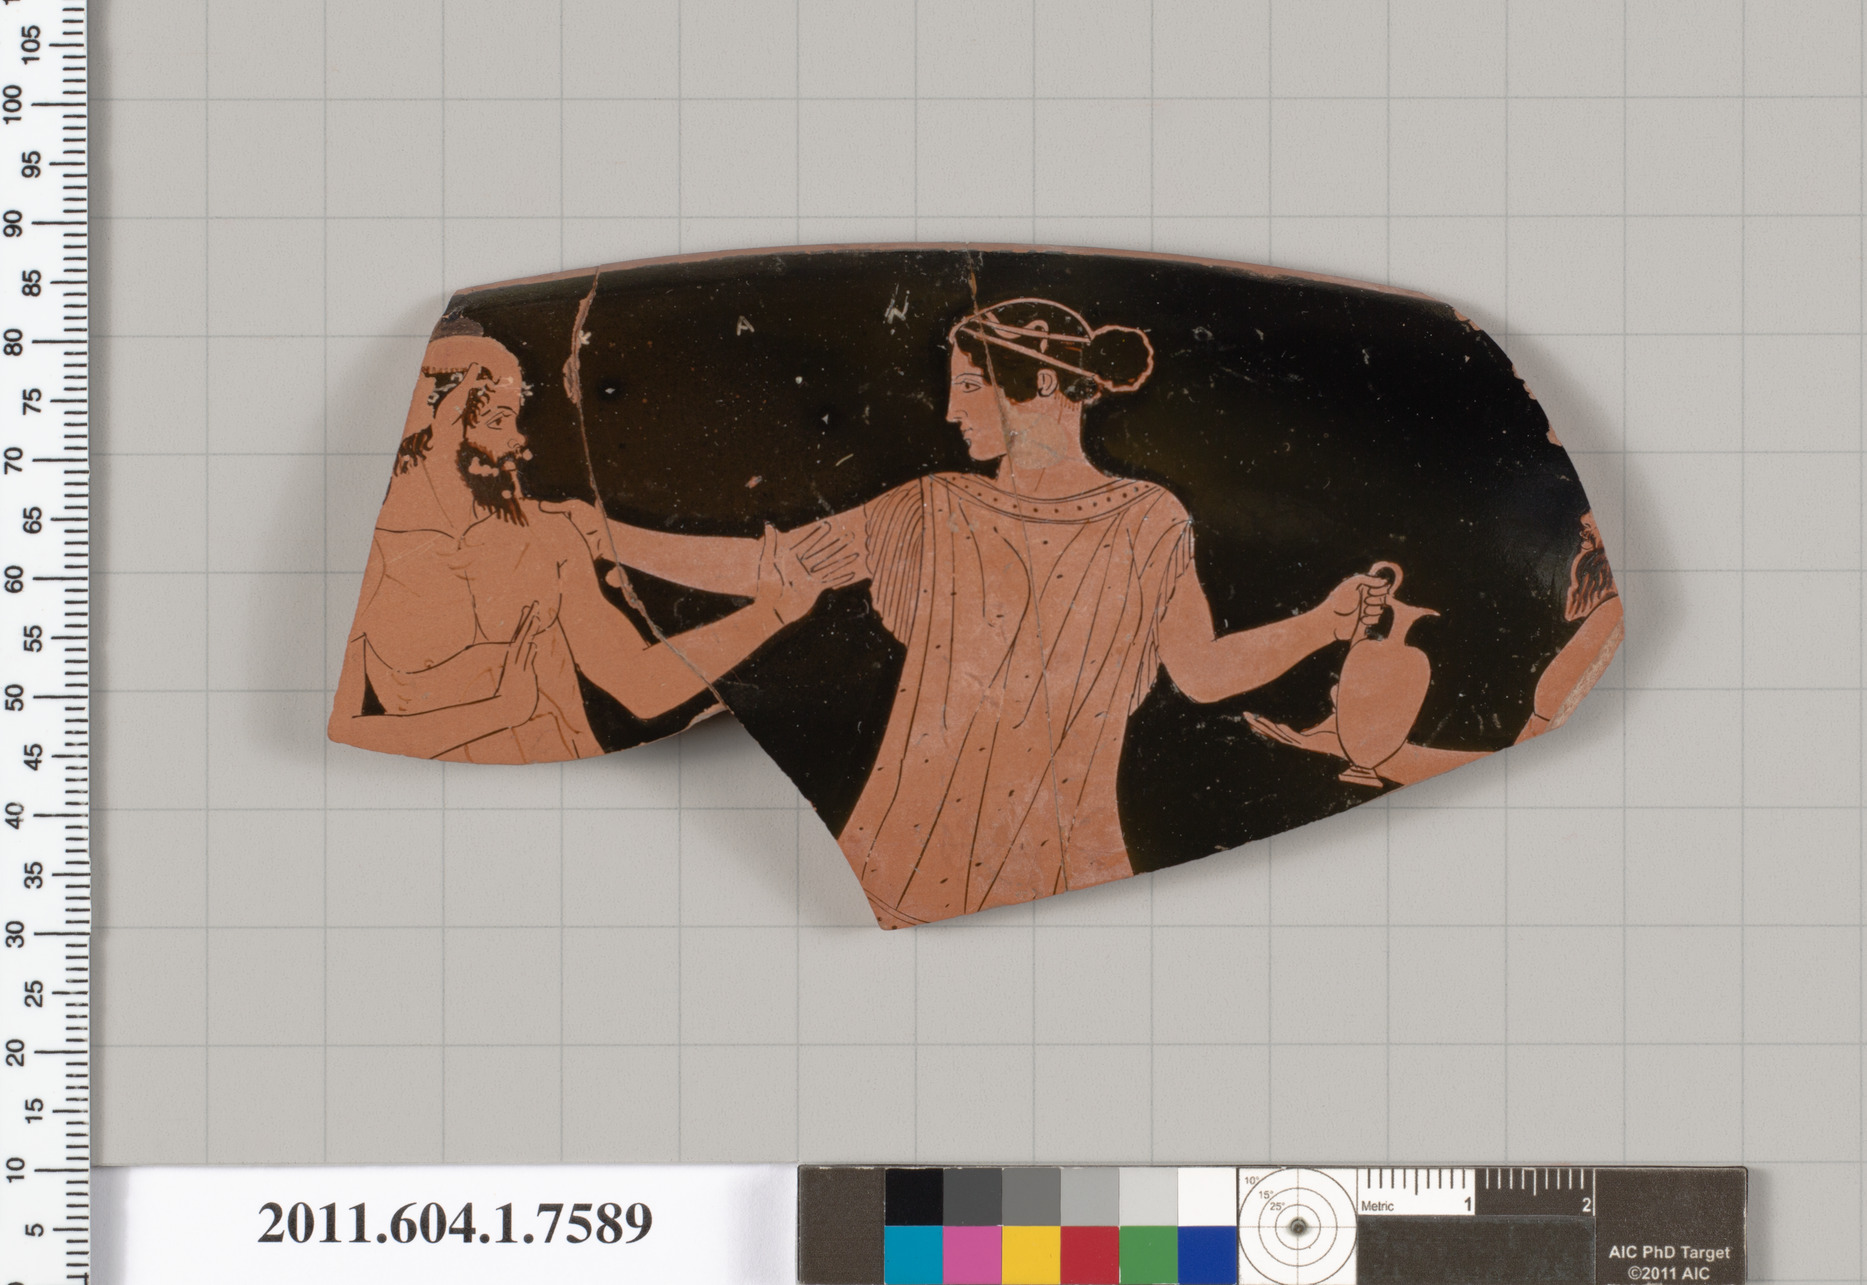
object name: kylix fragment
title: Terracotta rim fragment of a kylix (drinking cup)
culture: greek, attic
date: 460-450 BCE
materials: terracotta